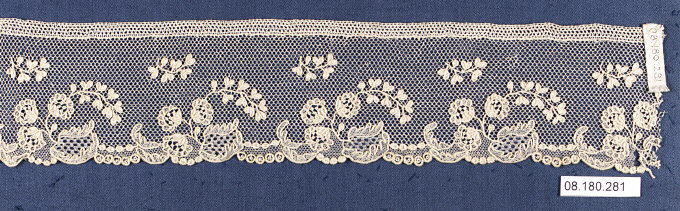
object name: fragment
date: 1776-1800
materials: hair, linen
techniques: lace